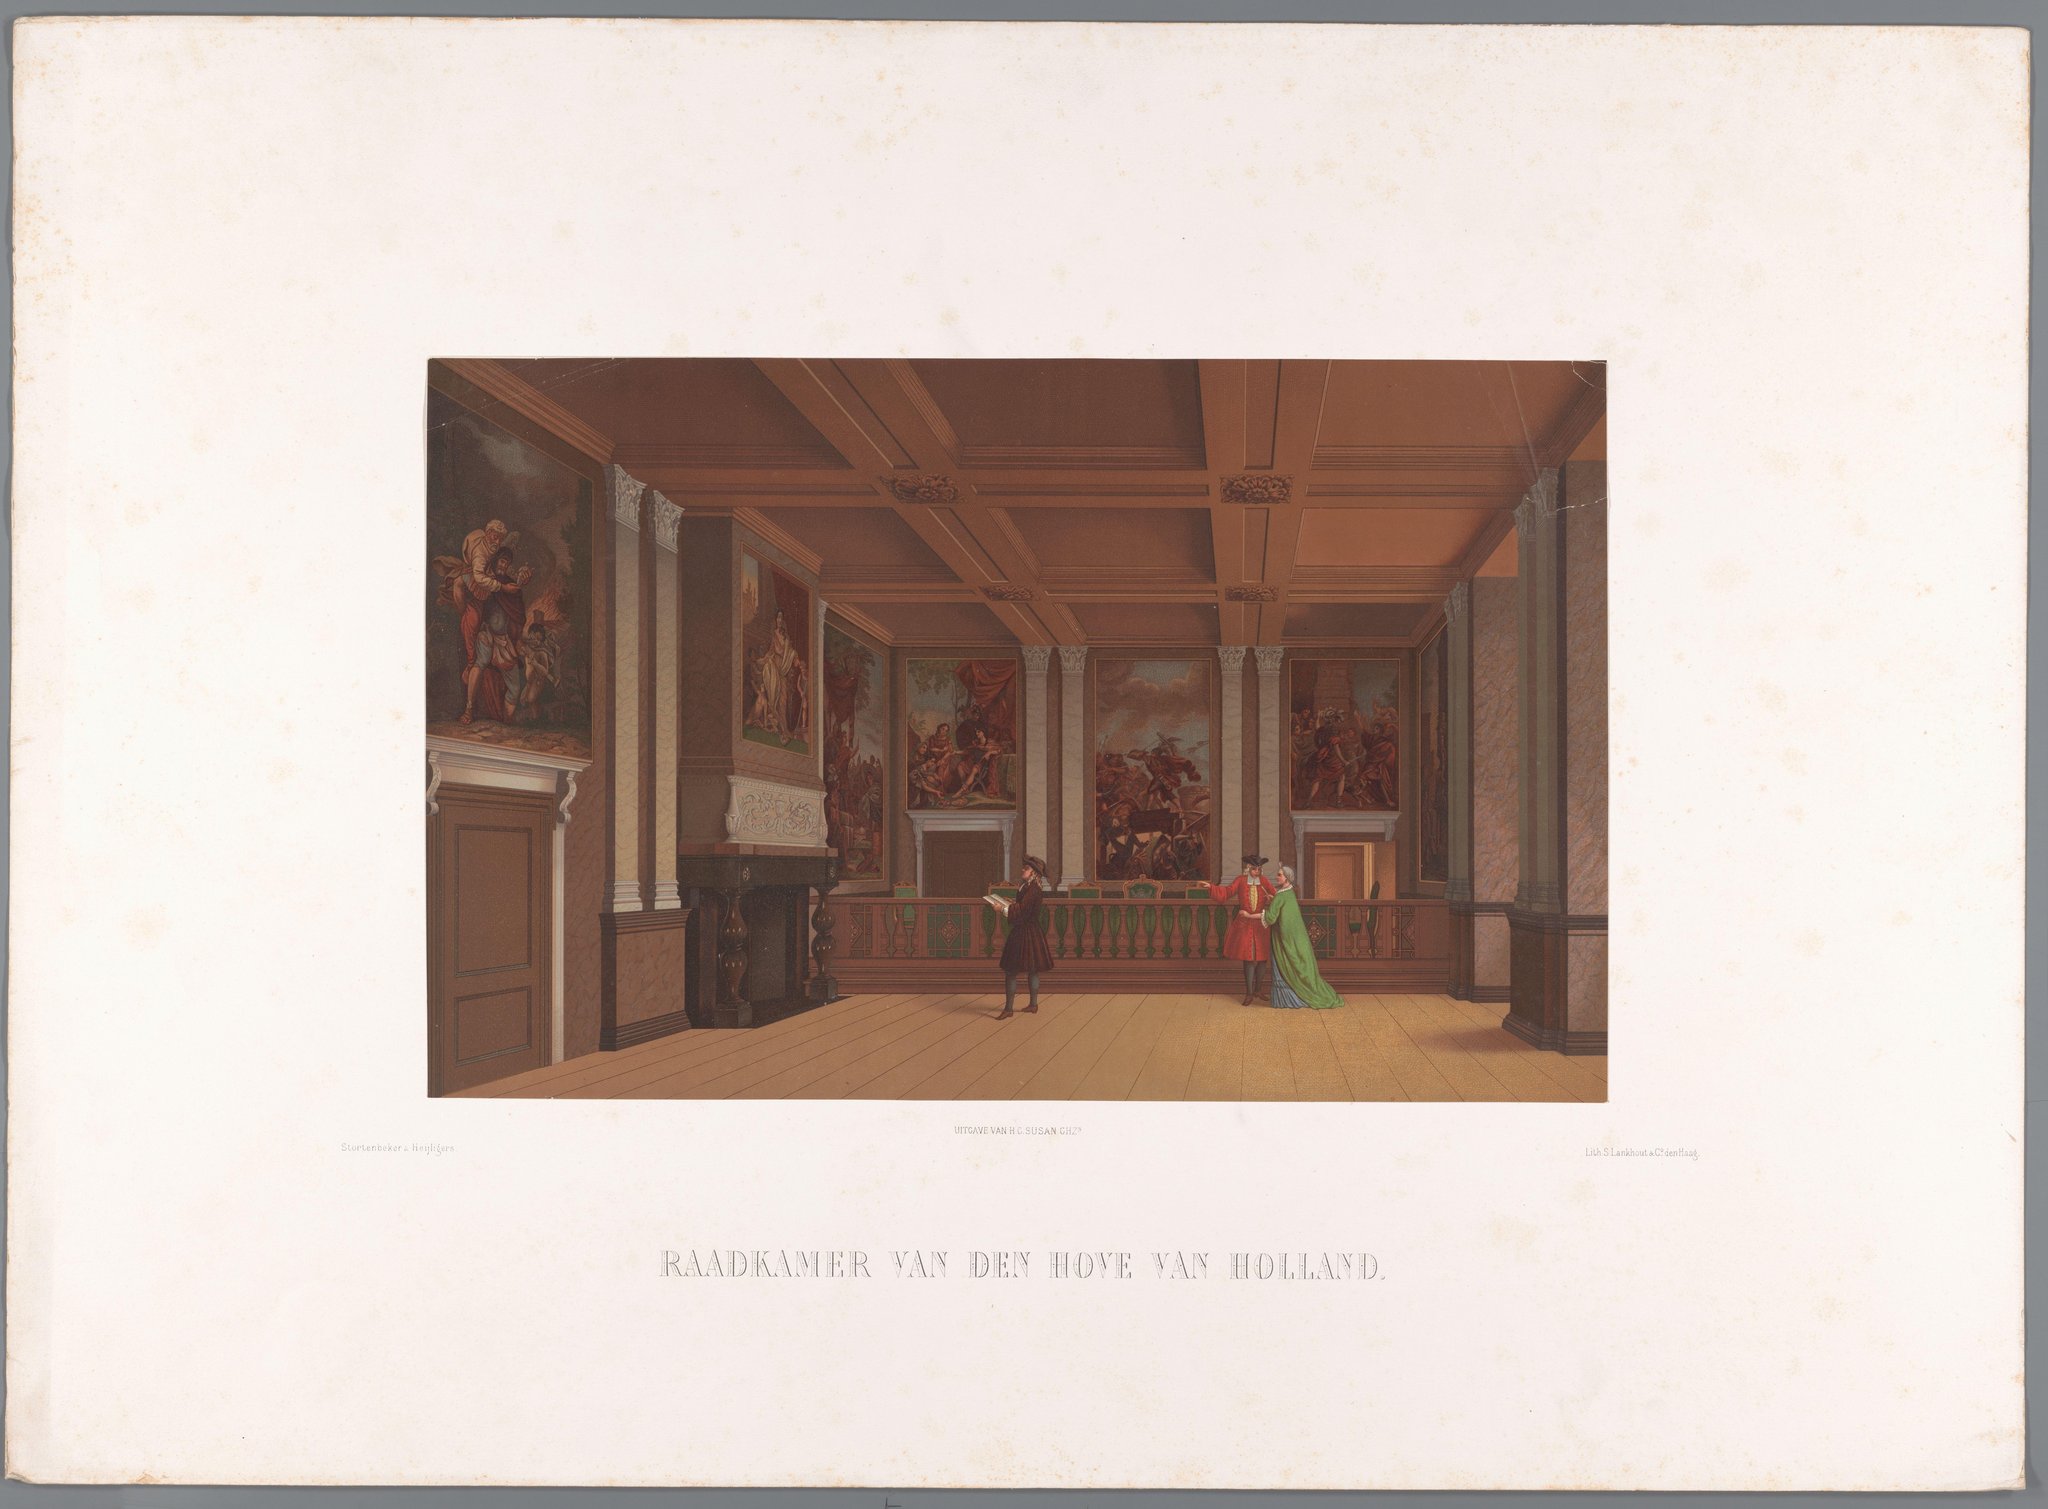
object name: print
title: Gezicht op het interieur van de Raadkamer, in de Grafelijke Zalen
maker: h.c. susan chzn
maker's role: publisher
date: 1879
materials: paper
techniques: lithograph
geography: the hague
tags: national government